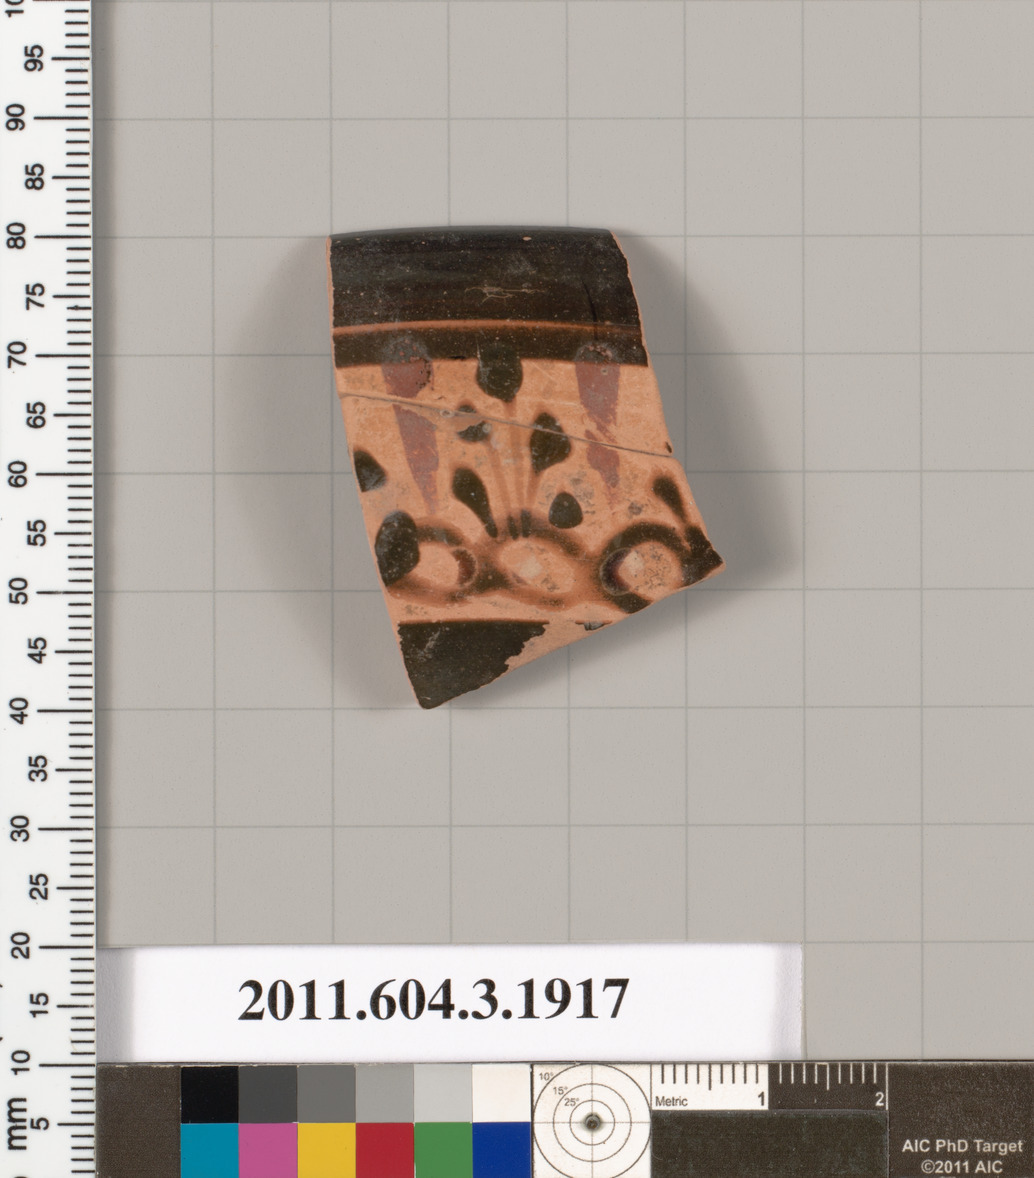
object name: kylix or skyphos fragment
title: Terracotta fragment of a kylix (drinking cup) or a skyphos (deep drinking cup)?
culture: greek, attic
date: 534-468 BCE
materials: terracotta